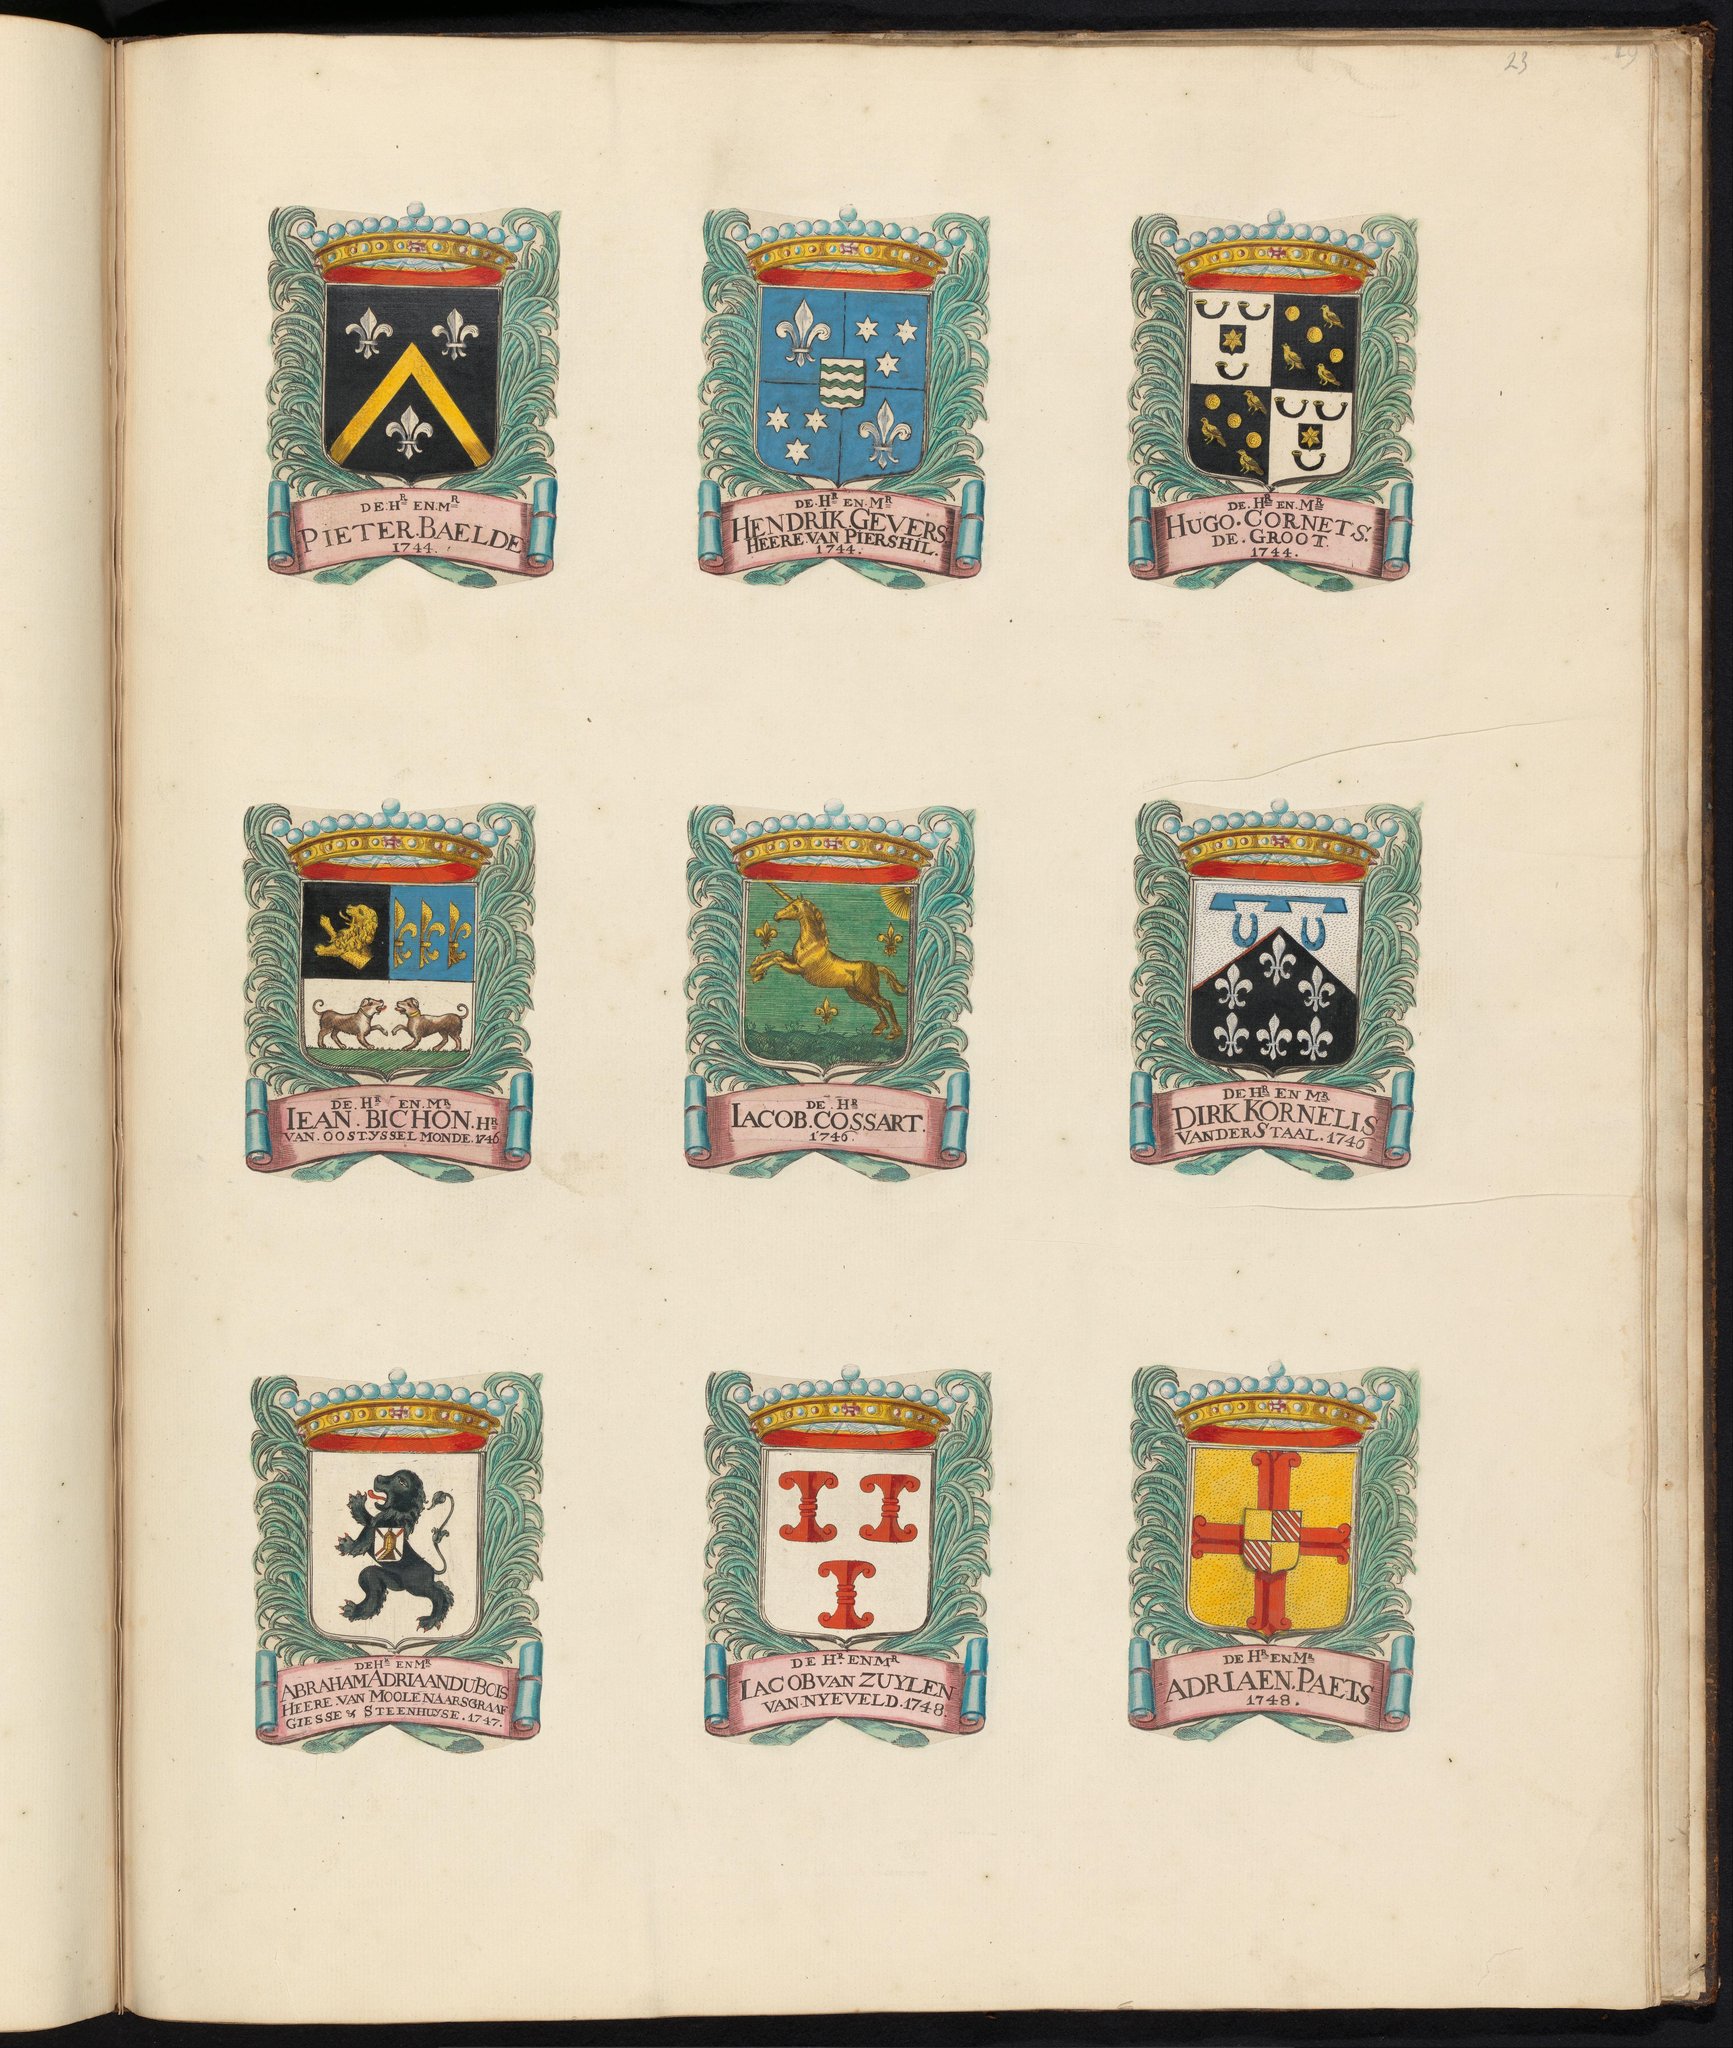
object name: album leaf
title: Negen wapens van raden in de vroedschap van Rotterdam, rechtsboven het wapen van Hugo Cornets de Groot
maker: Anonymous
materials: paper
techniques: colour, etching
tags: rotterdam, coat of arms (as symbol of the state, etc.)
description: Negen voorstellingen op een albumblad. Het betreft negen wapen van raden in de vroedschap van Rotterdam. De prenten zijn onderdeel van de kaart van Rotterdam door Johannes de Vouw en maken deel uit van een album.